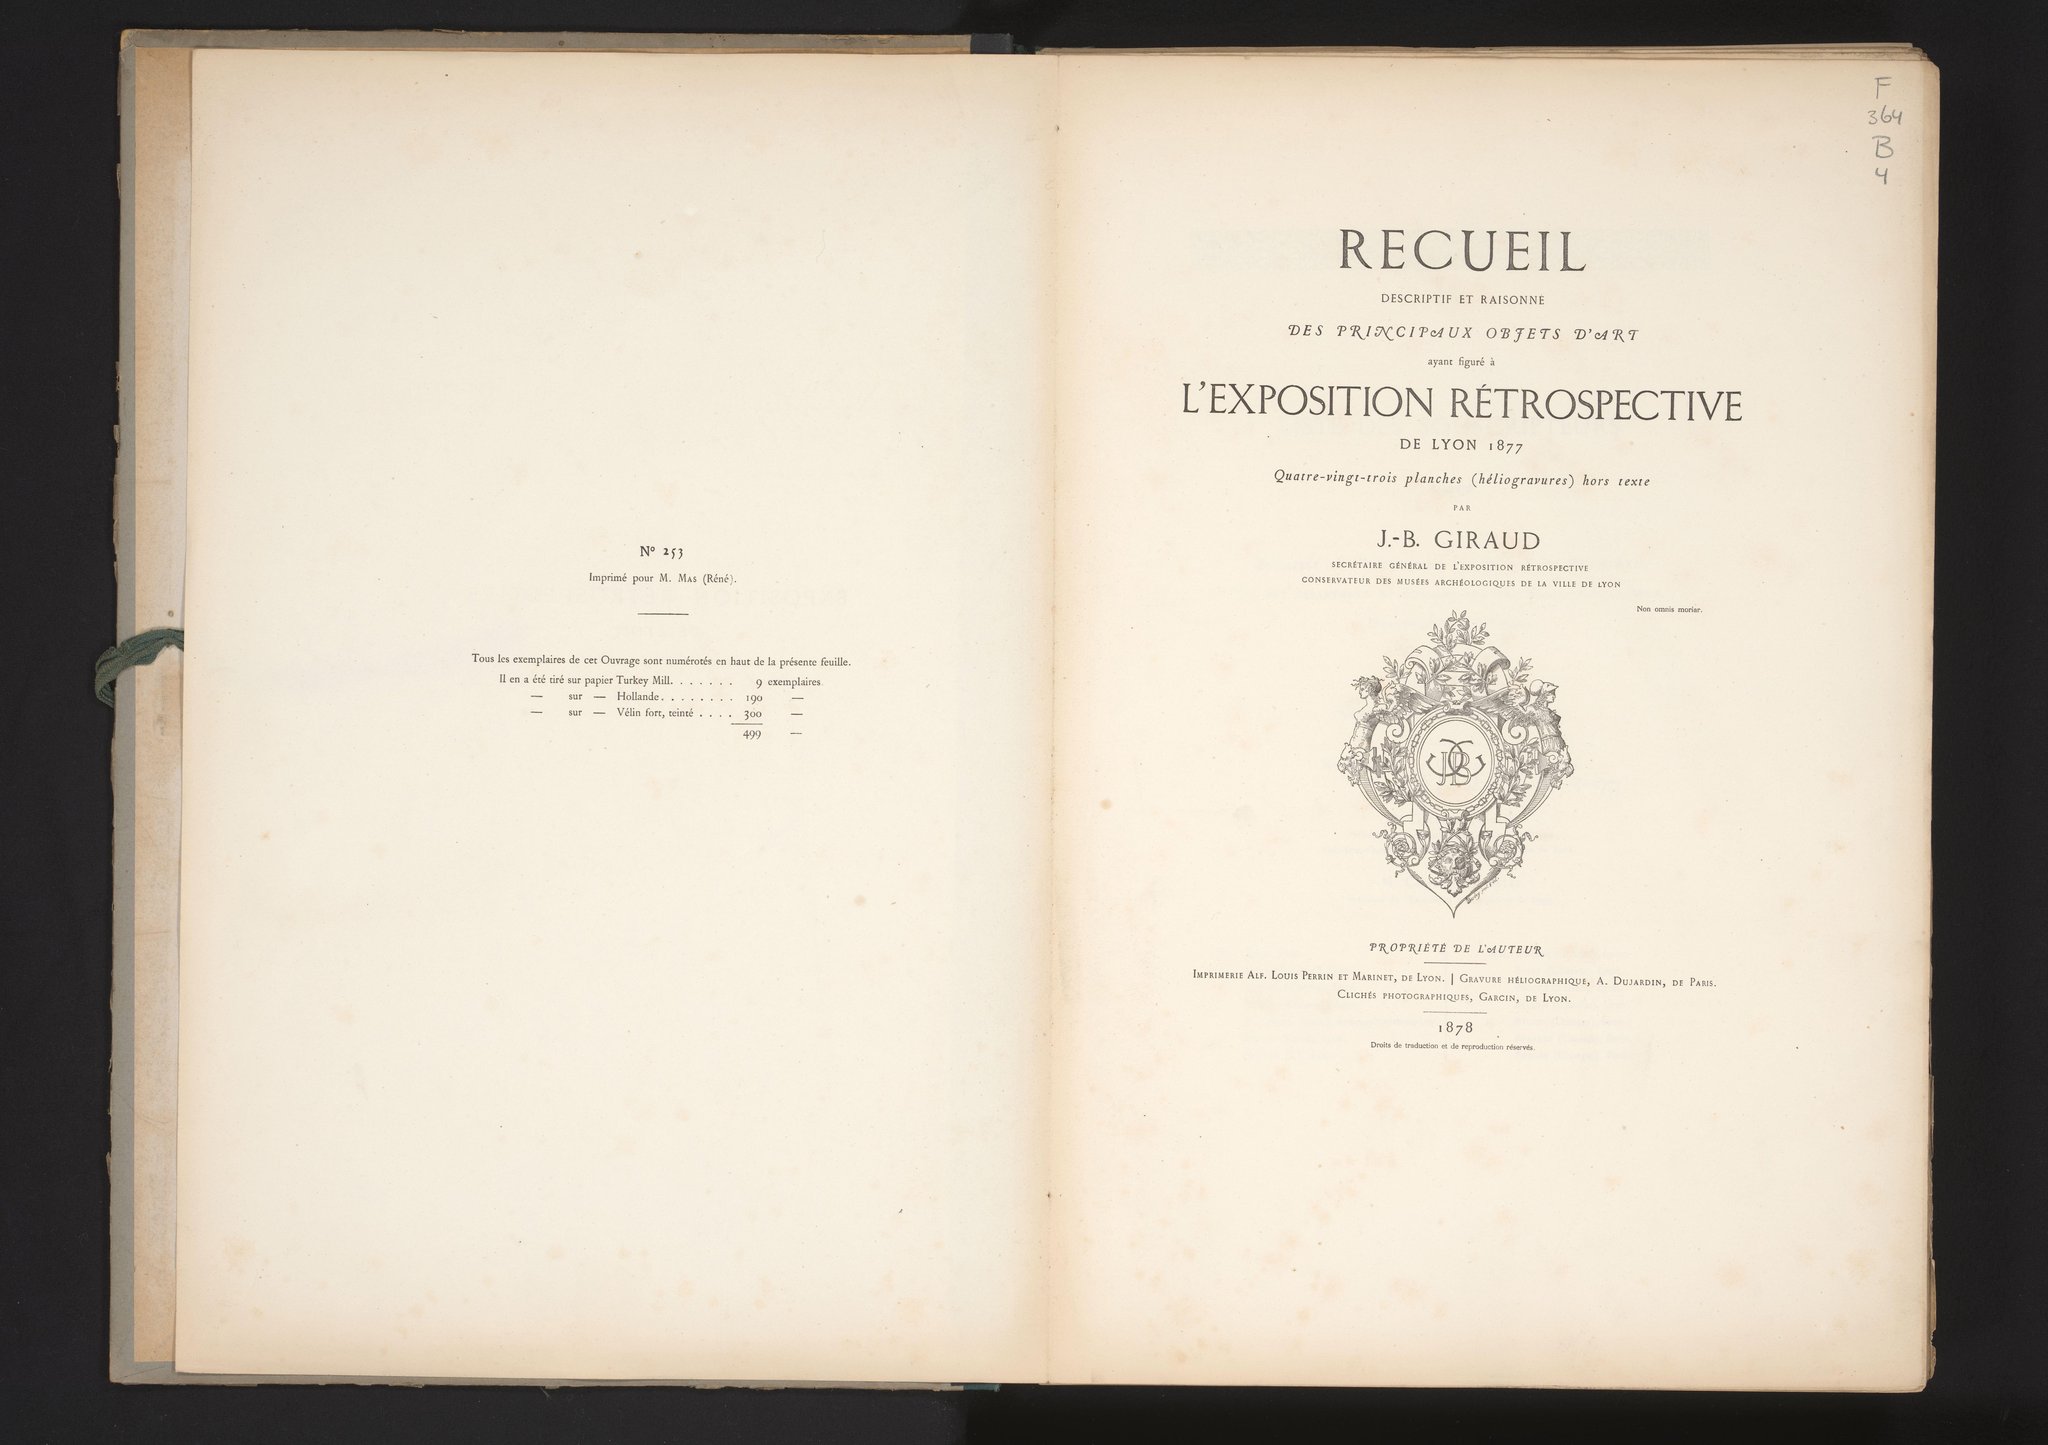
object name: wrapper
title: Recueil descriptif et raisonné des principaux objets d'art ayant figuré à l'exposition rétrospective de Lyon 1877 / J.B. Giraud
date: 1878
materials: cardboard, linen, paper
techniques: photoaquatint, printing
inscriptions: retailer's mark: ‘POSADA/ art-books/ Rue de la Madeleine 27/ 1000 Brussels-02/511.08.34’, number: ‘2800’, date: ‘JULY/ 1988’, number: ‘1868’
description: Omslag met 79 prenten op 54 bladen en 65 tekstbladen.